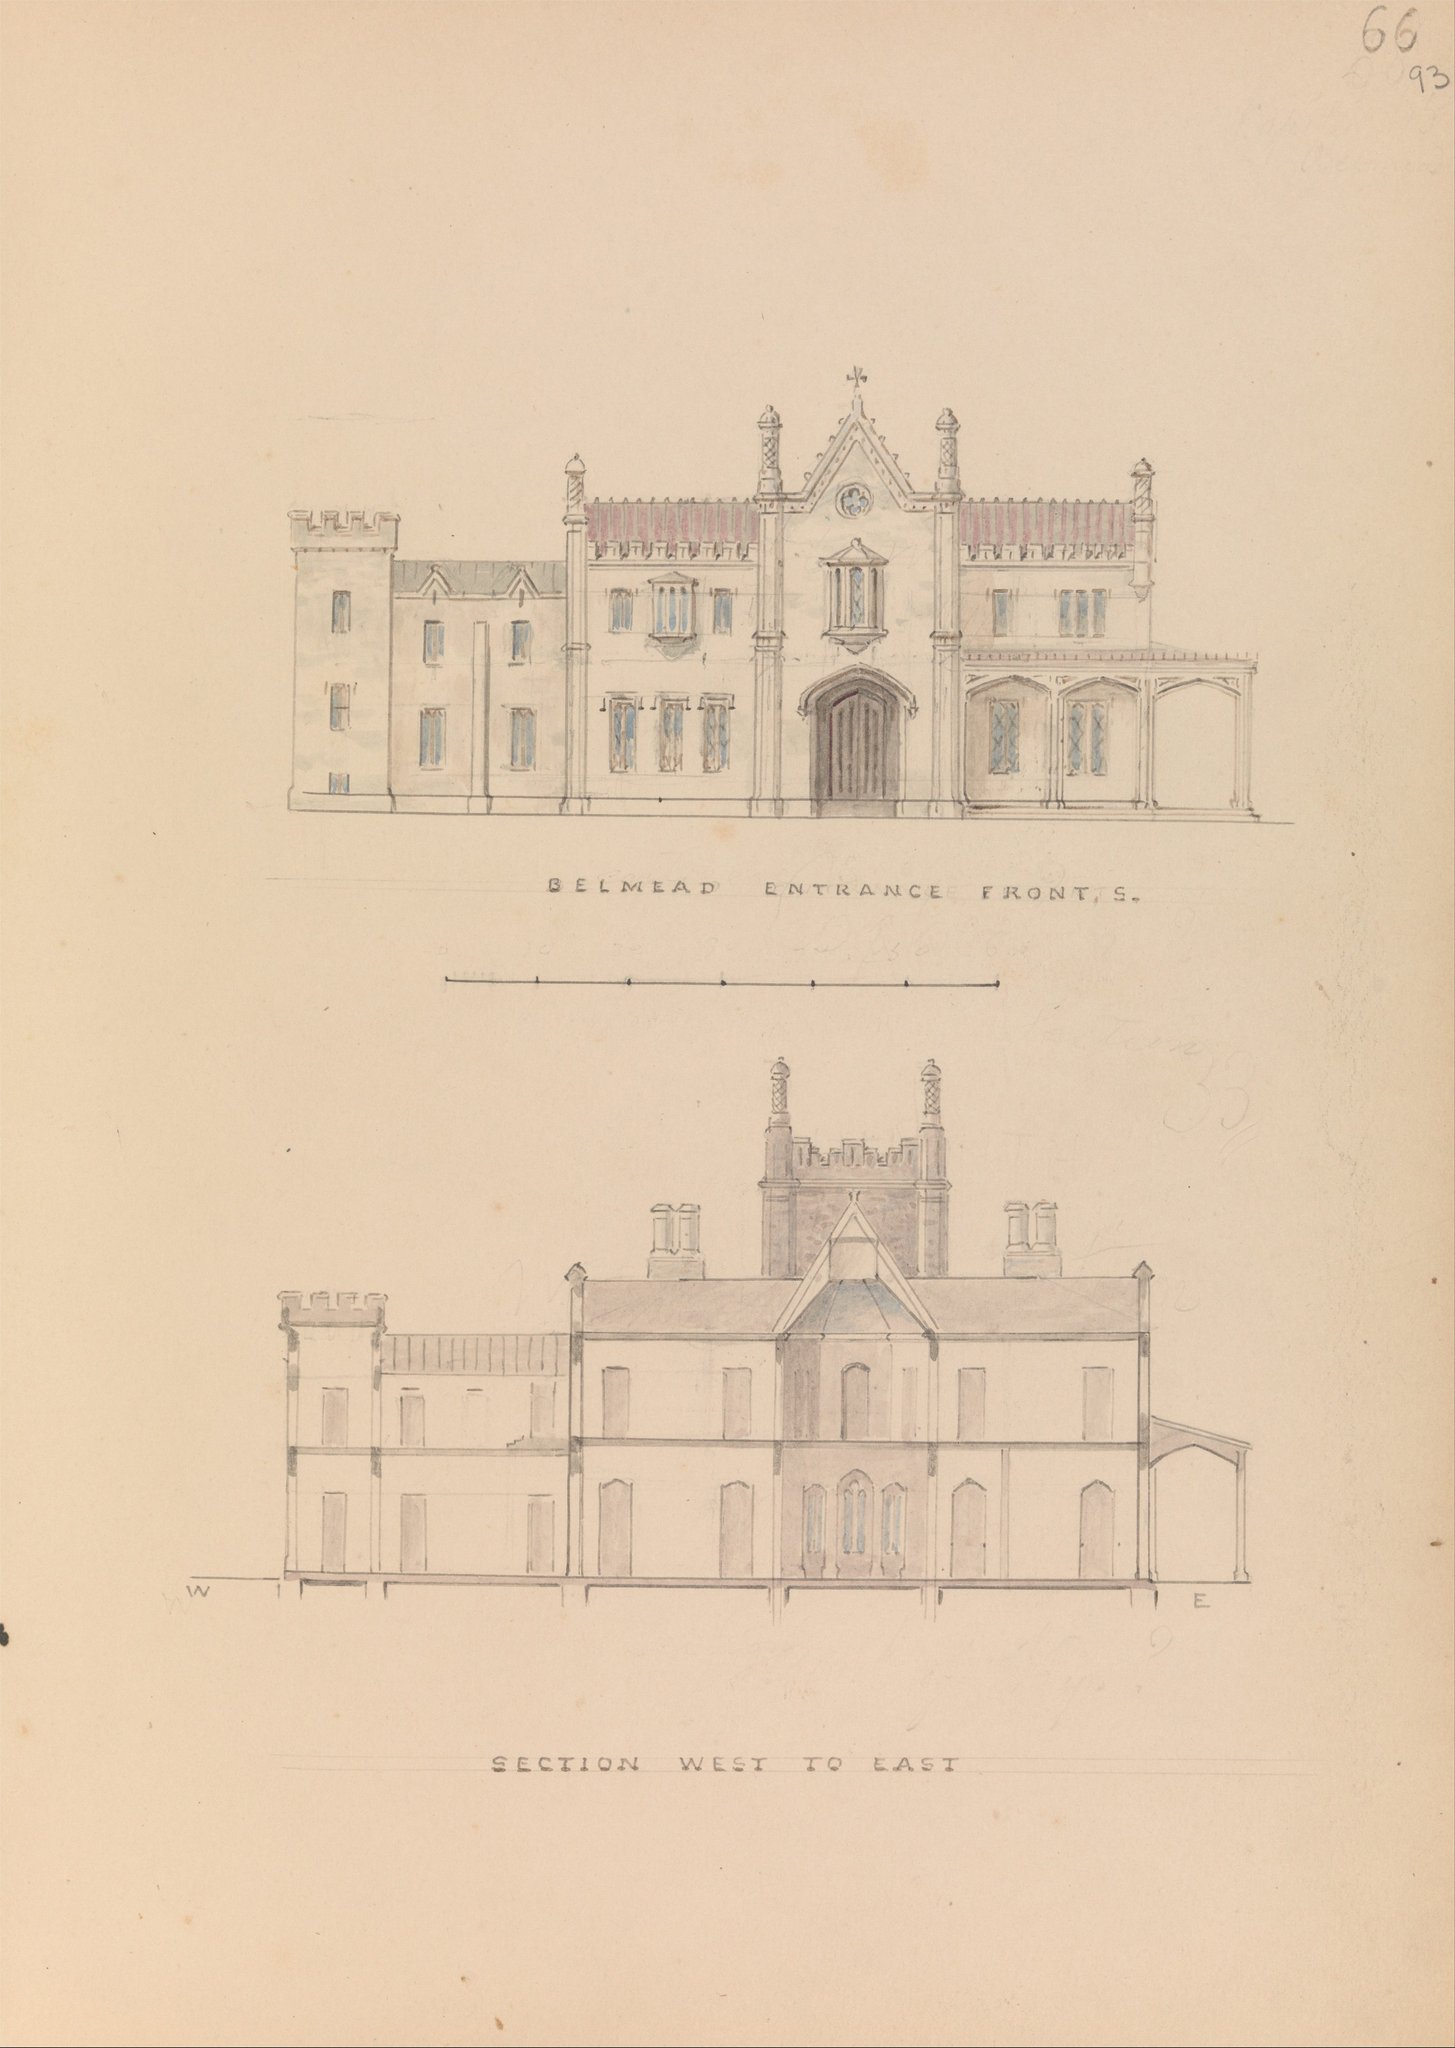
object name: drawing ornament architecture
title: "Belmead", James River, Virginia: Entrance façade and west-east section (recto); North-south section and upper floorplan (verso)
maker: alexander jackson davis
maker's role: artist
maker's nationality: american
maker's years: 1803-1892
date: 1845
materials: ink, watercolor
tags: architecture,houses